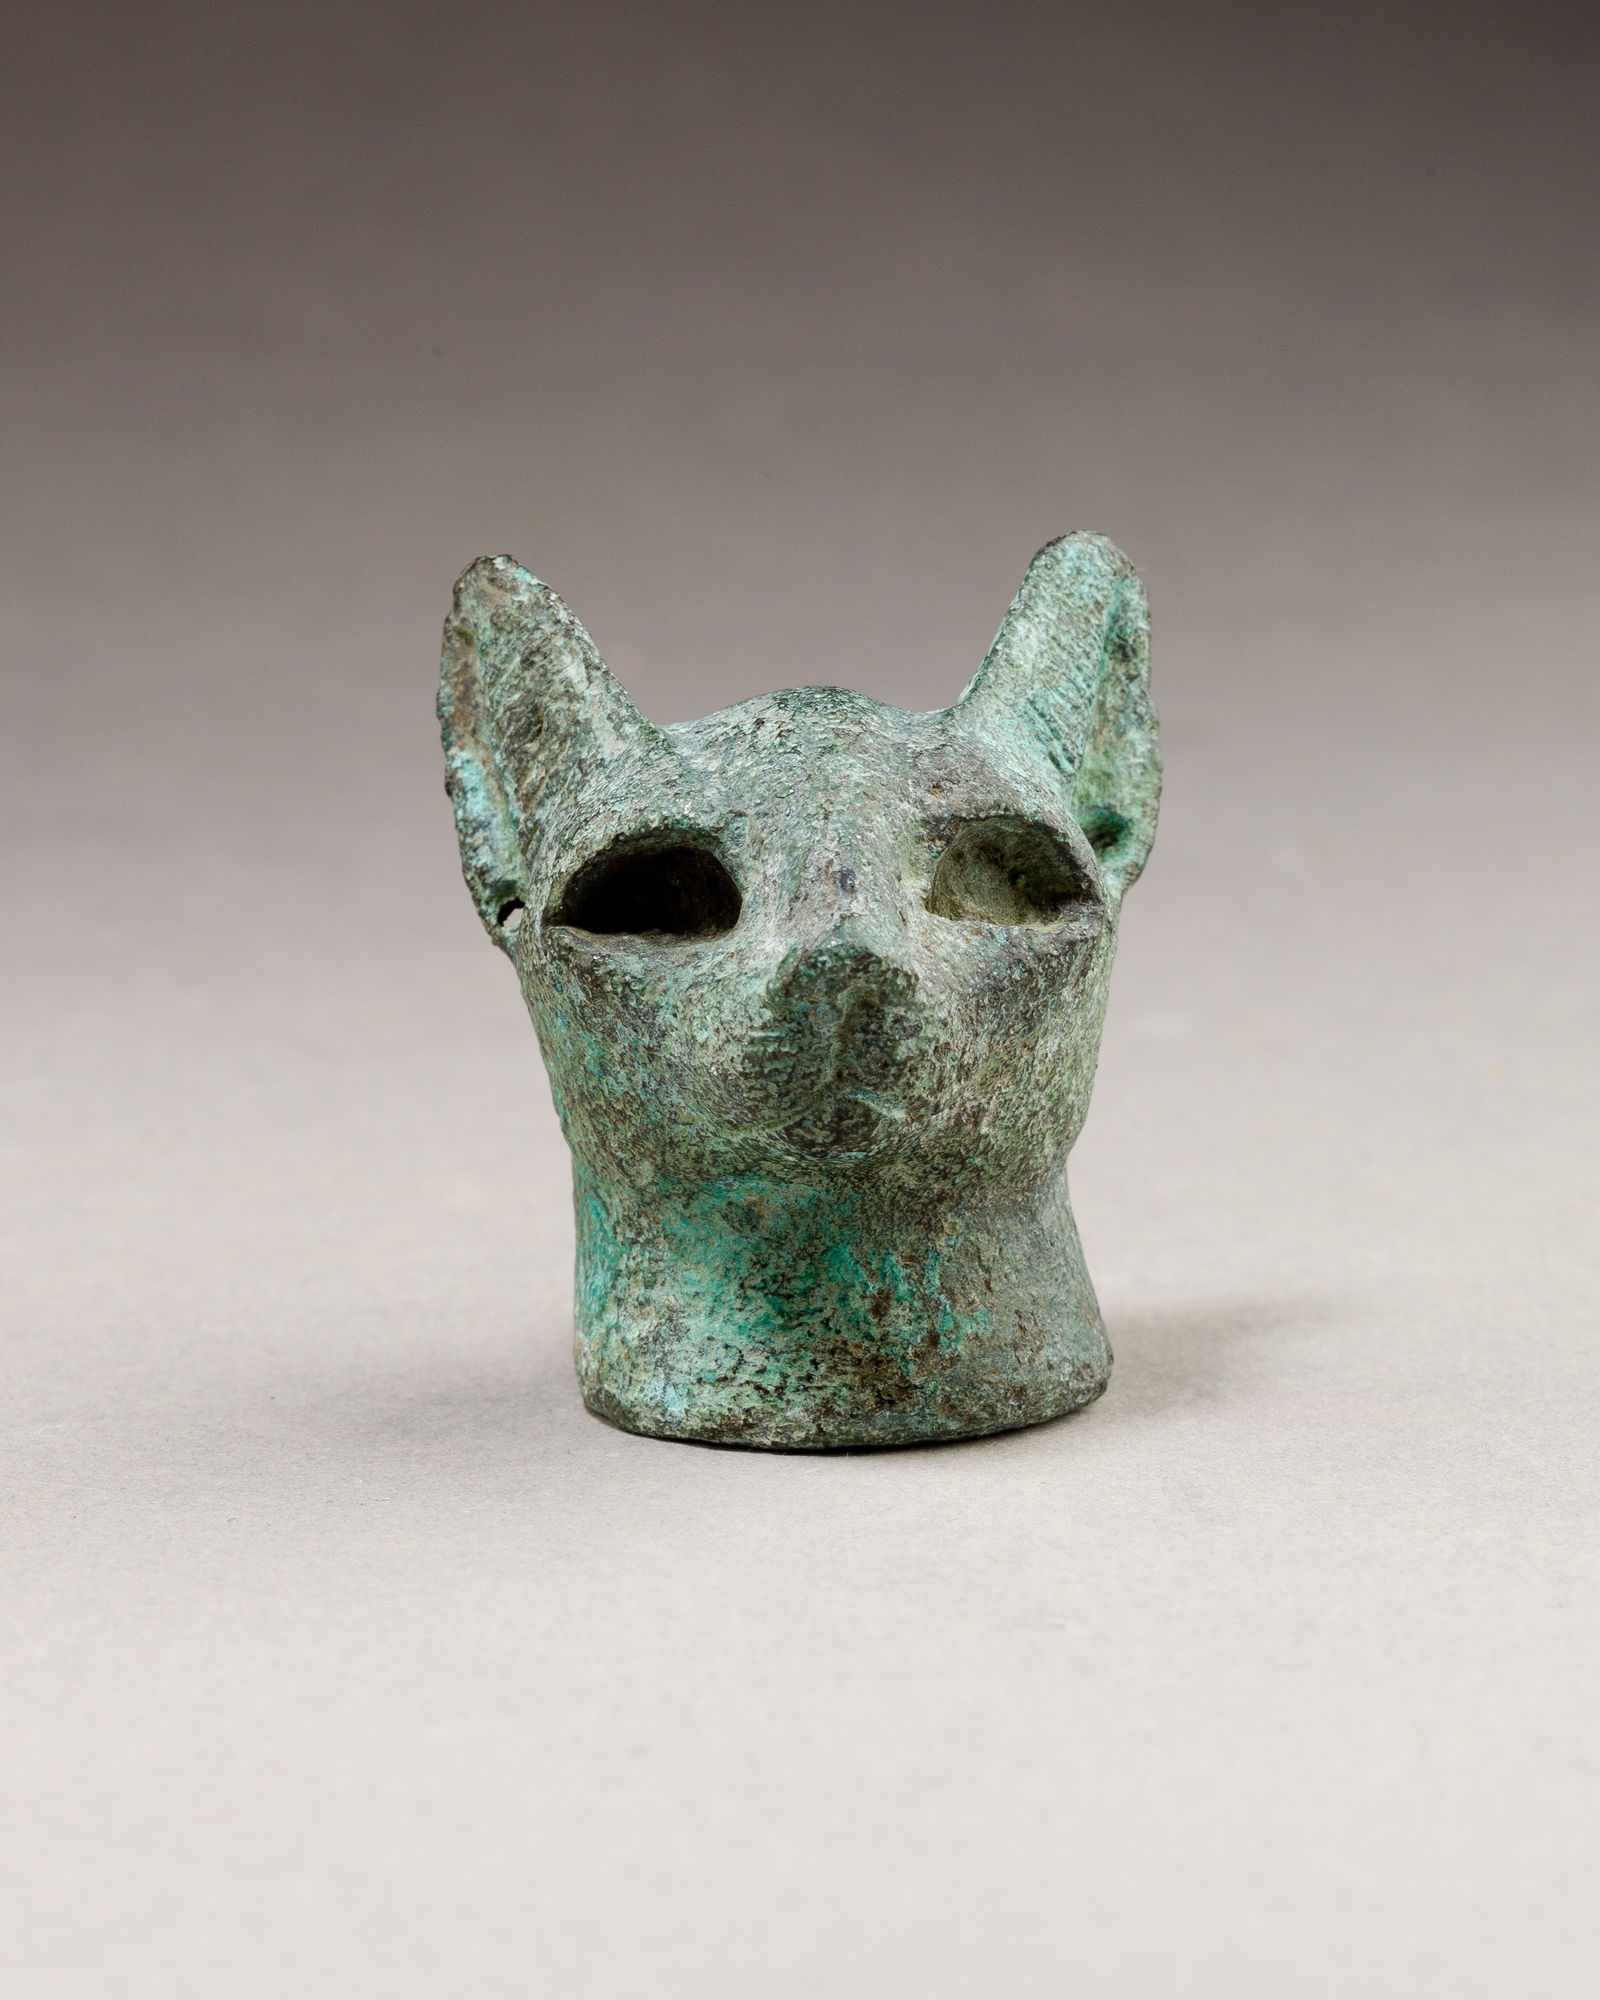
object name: head, cat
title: Head of a cat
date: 664-630 BCE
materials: metal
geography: egypt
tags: cats